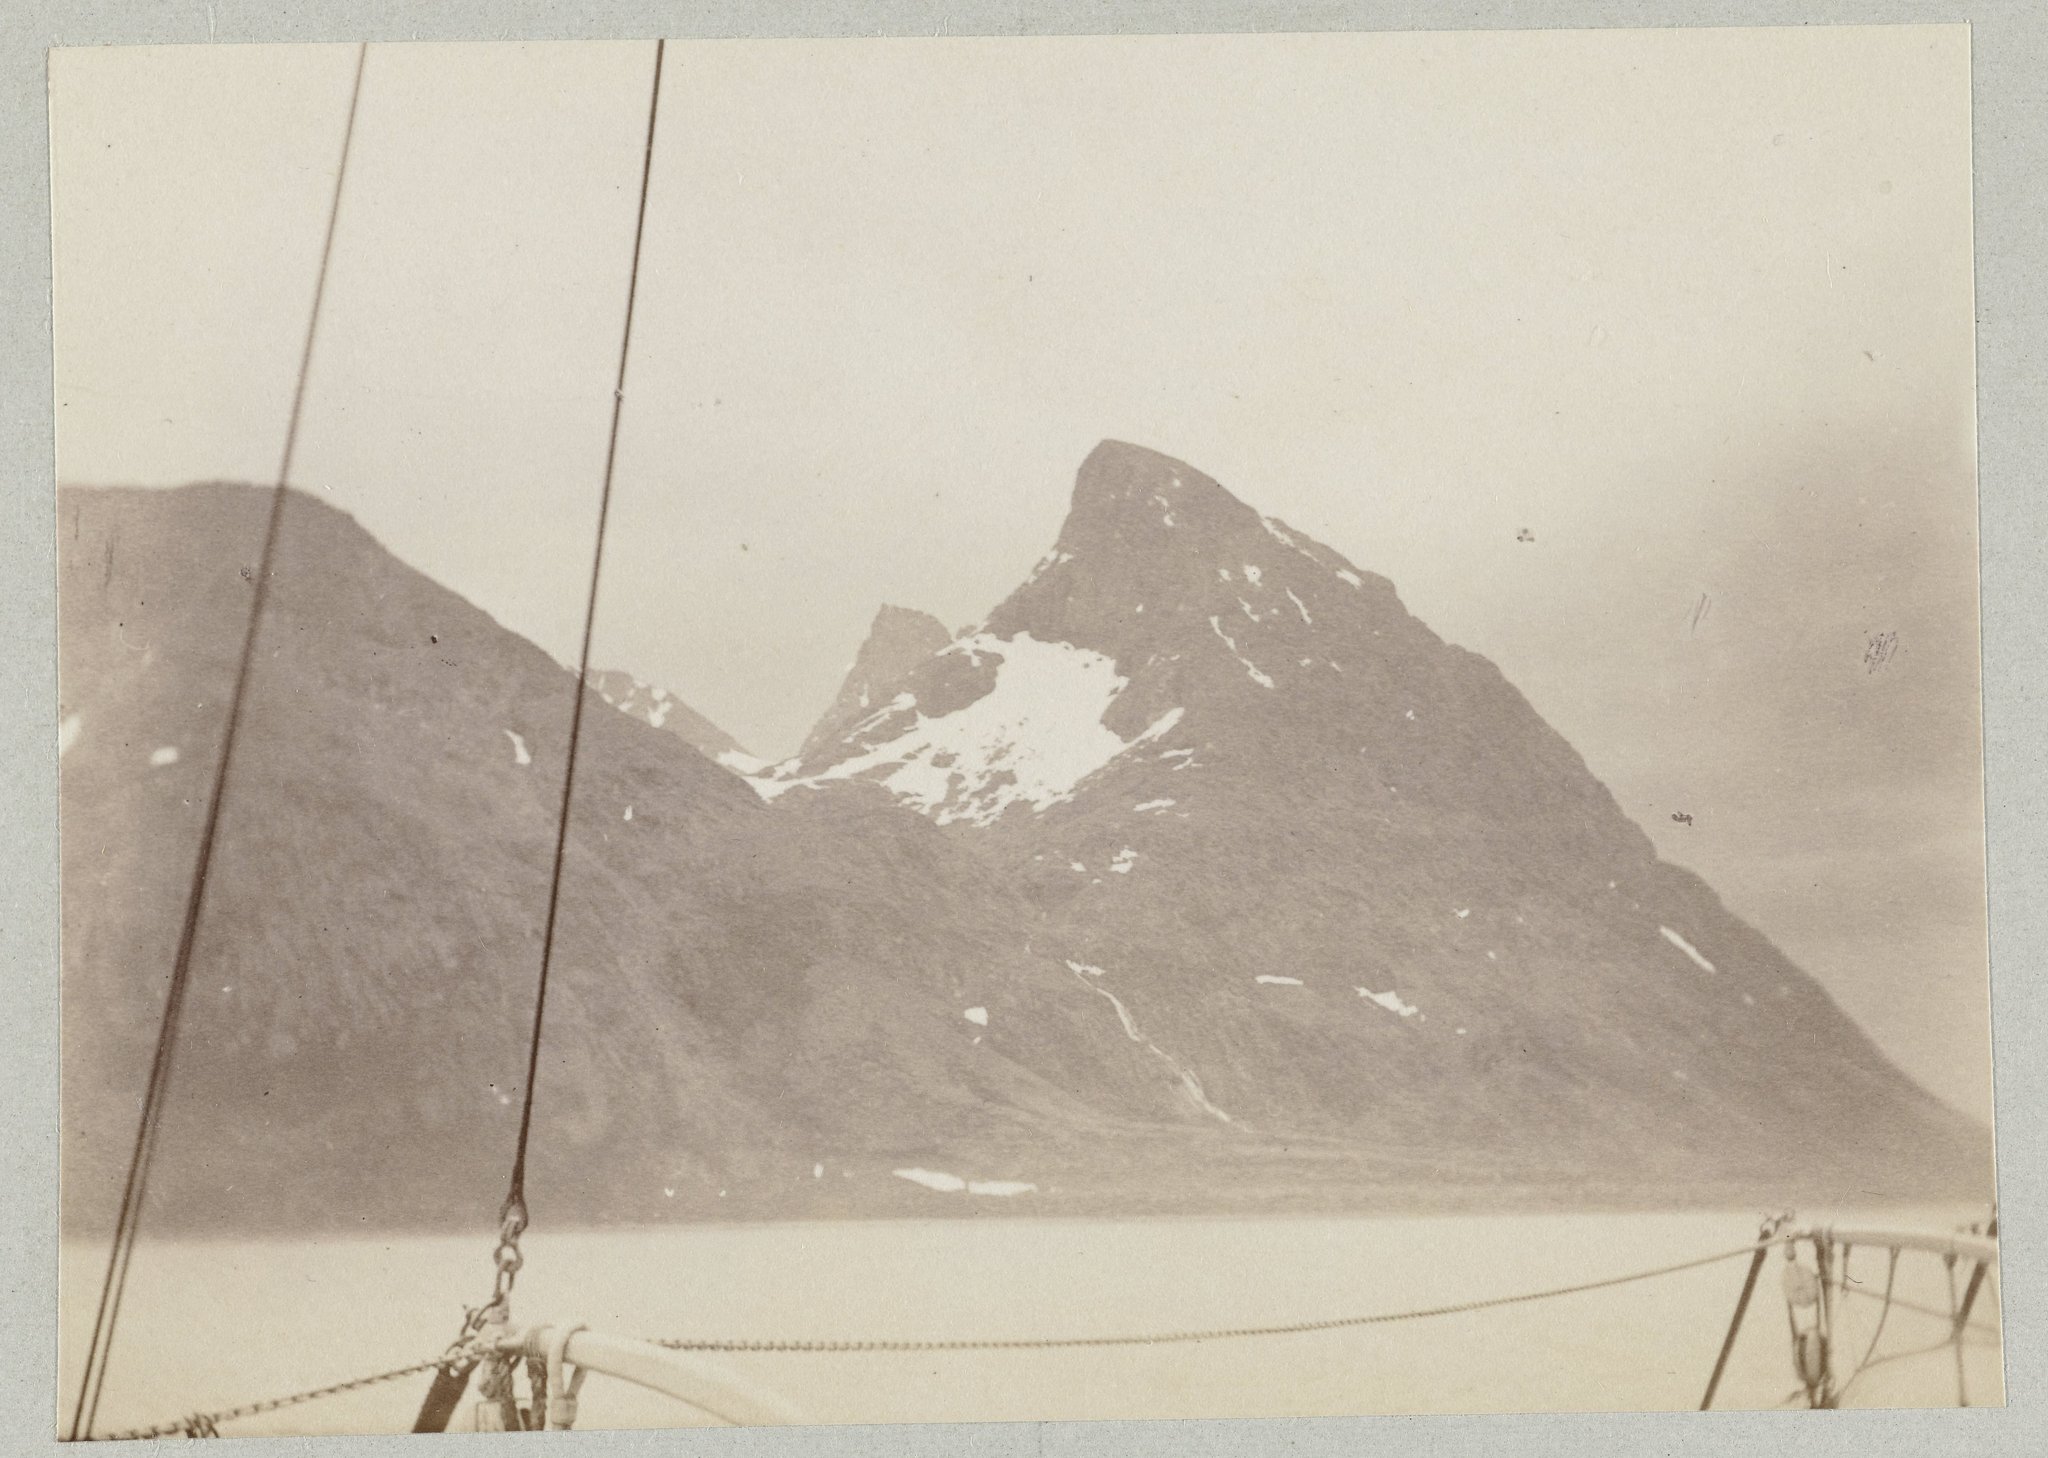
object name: photograph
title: Auf Carisö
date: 1807-1889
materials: cardboard, paper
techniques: albumen print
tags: wilhelm ii (keizer van duitsland), norway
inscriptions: number: ‘31’